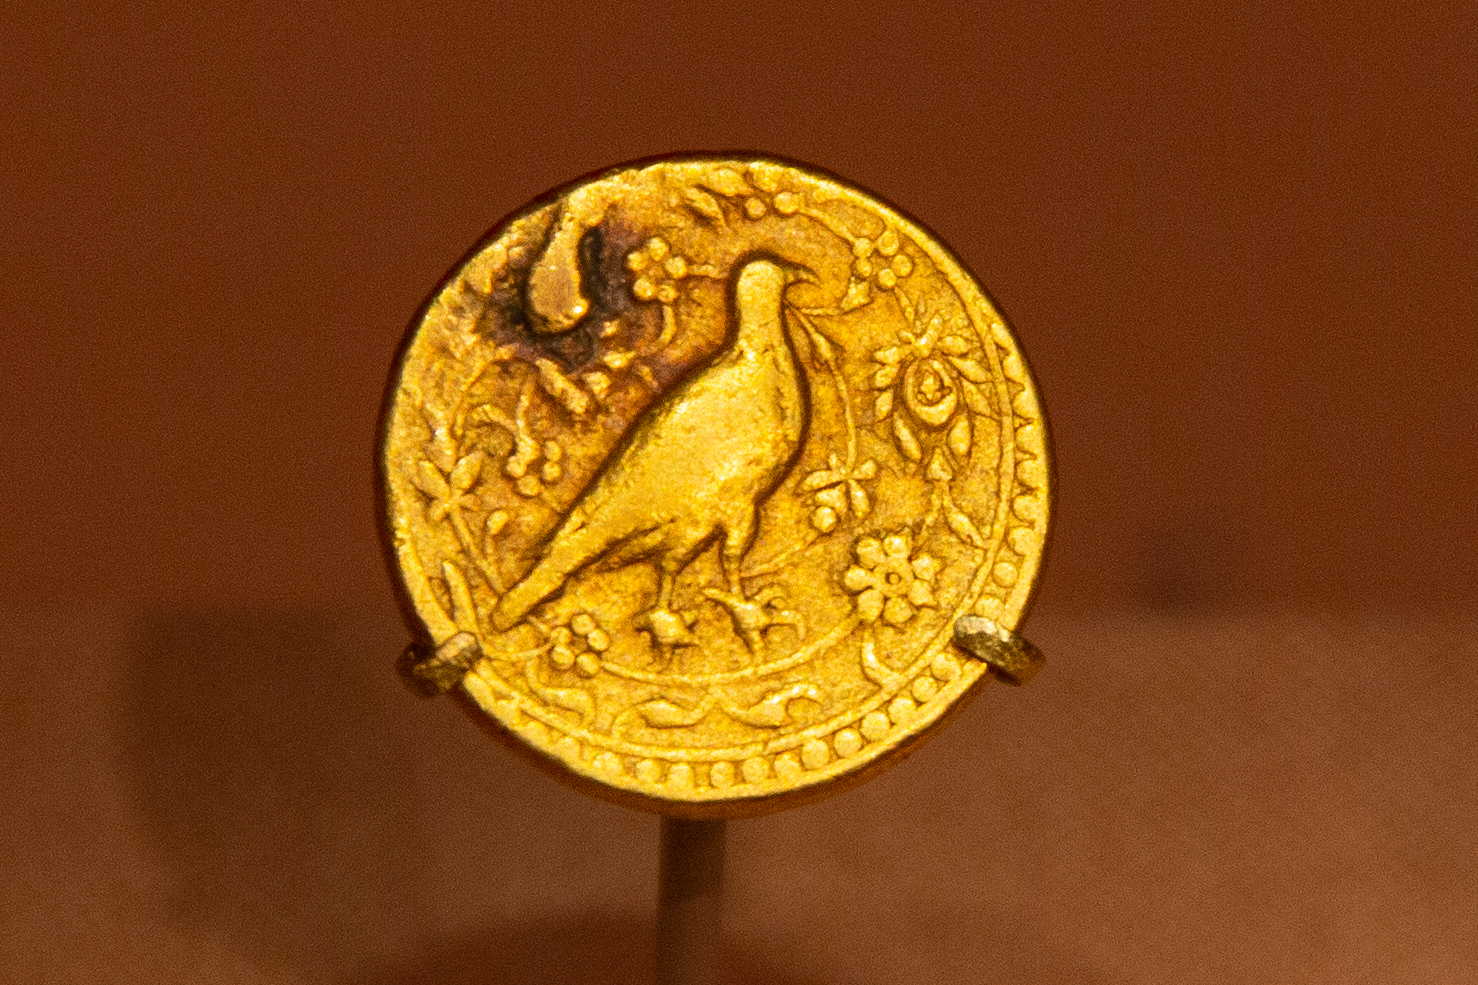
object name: coin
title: Hawk Coin of the Emperor Akbar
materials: gold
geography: india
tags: hawks